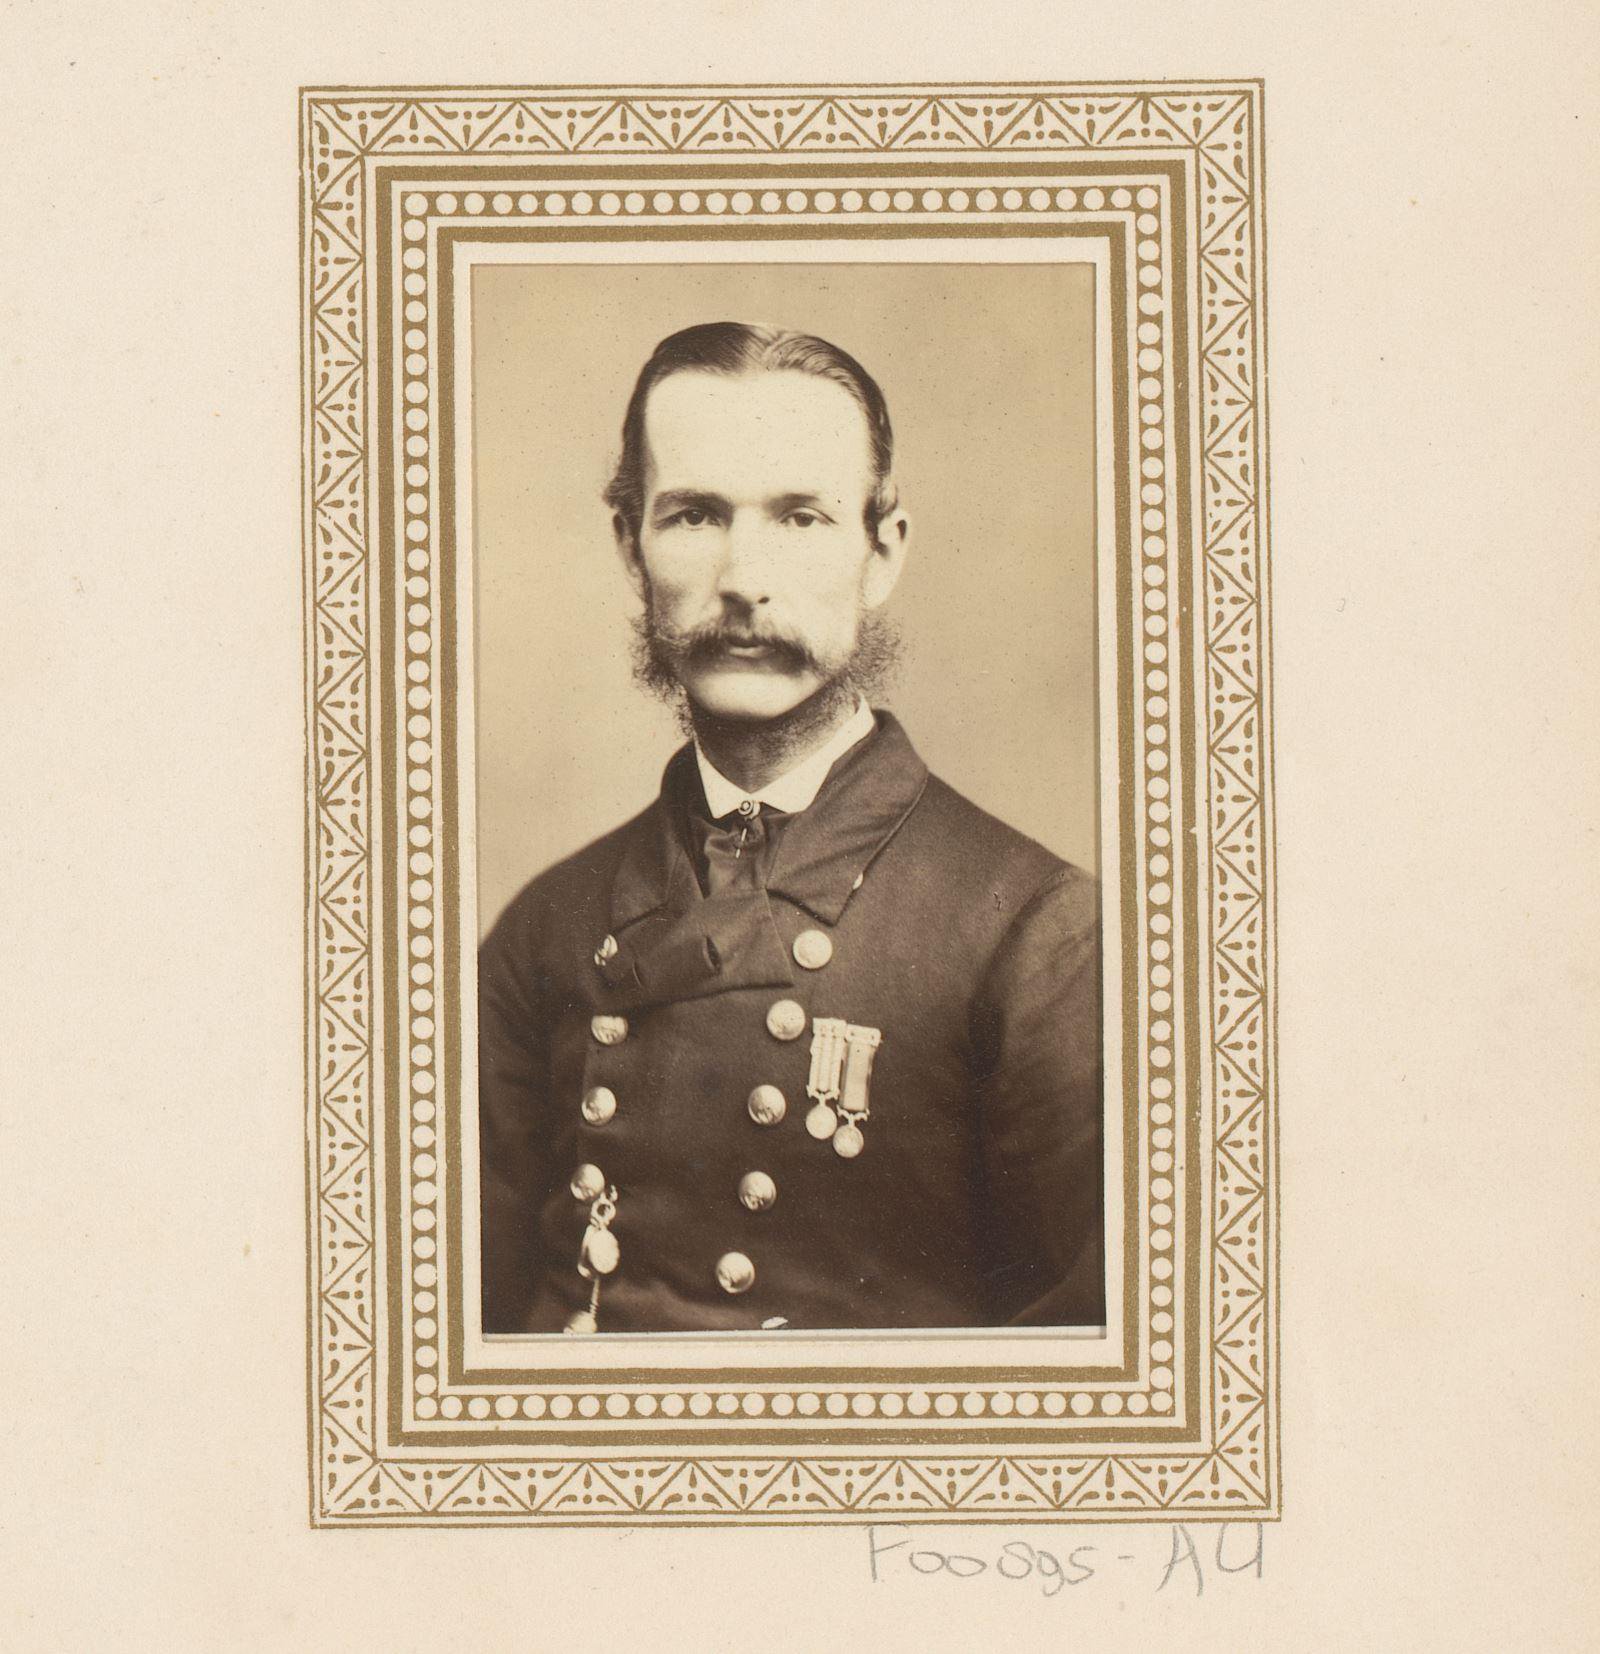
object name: album leaf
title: Portret van een man met snor en in uniform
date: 1812-1867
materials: cardboard, photographic support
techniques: albumen print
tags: moustache, adult man, historical persons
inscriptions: annotation: ‘Mrs E. [Booker]/ Dec[...]/ 67’, inscription: ‘226 Oxford St 228/ The West End Photographic Company/ between/ Quebec STreet & Portman Street/ Established 1854’